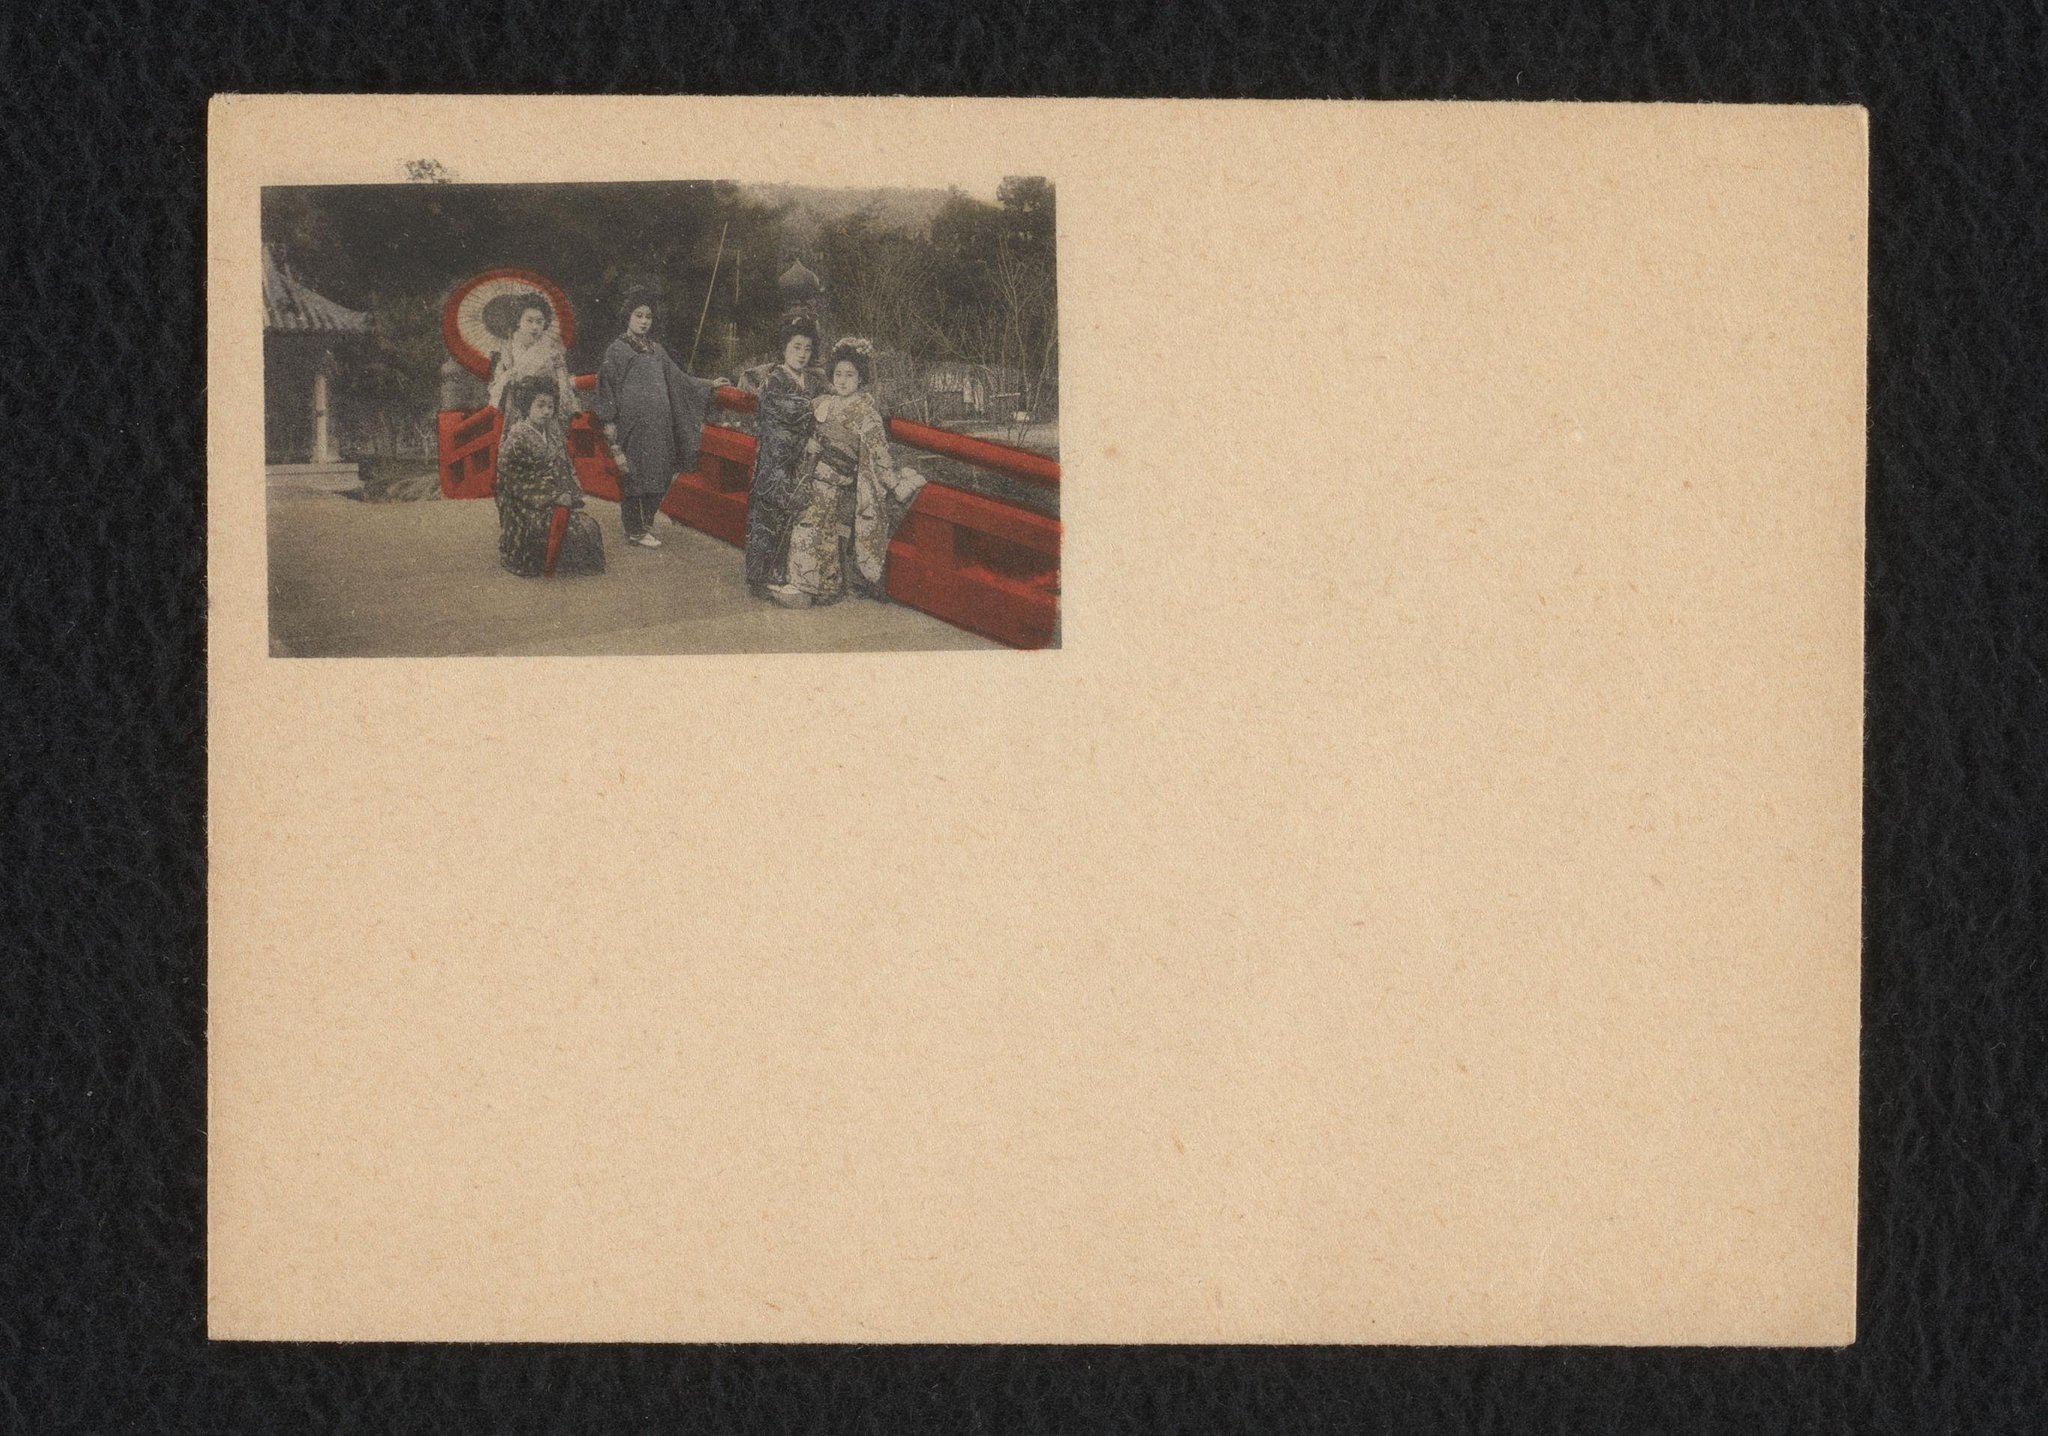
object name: envelope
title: Groep van vijf onbekende Japanse vrouwen op een brug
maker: Anonymous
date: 1890-1920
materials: paper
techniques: photograph, lithograph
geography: japan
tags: anonymous historical persons portrayed in a group, in a group-portrait - bb - woman, japan